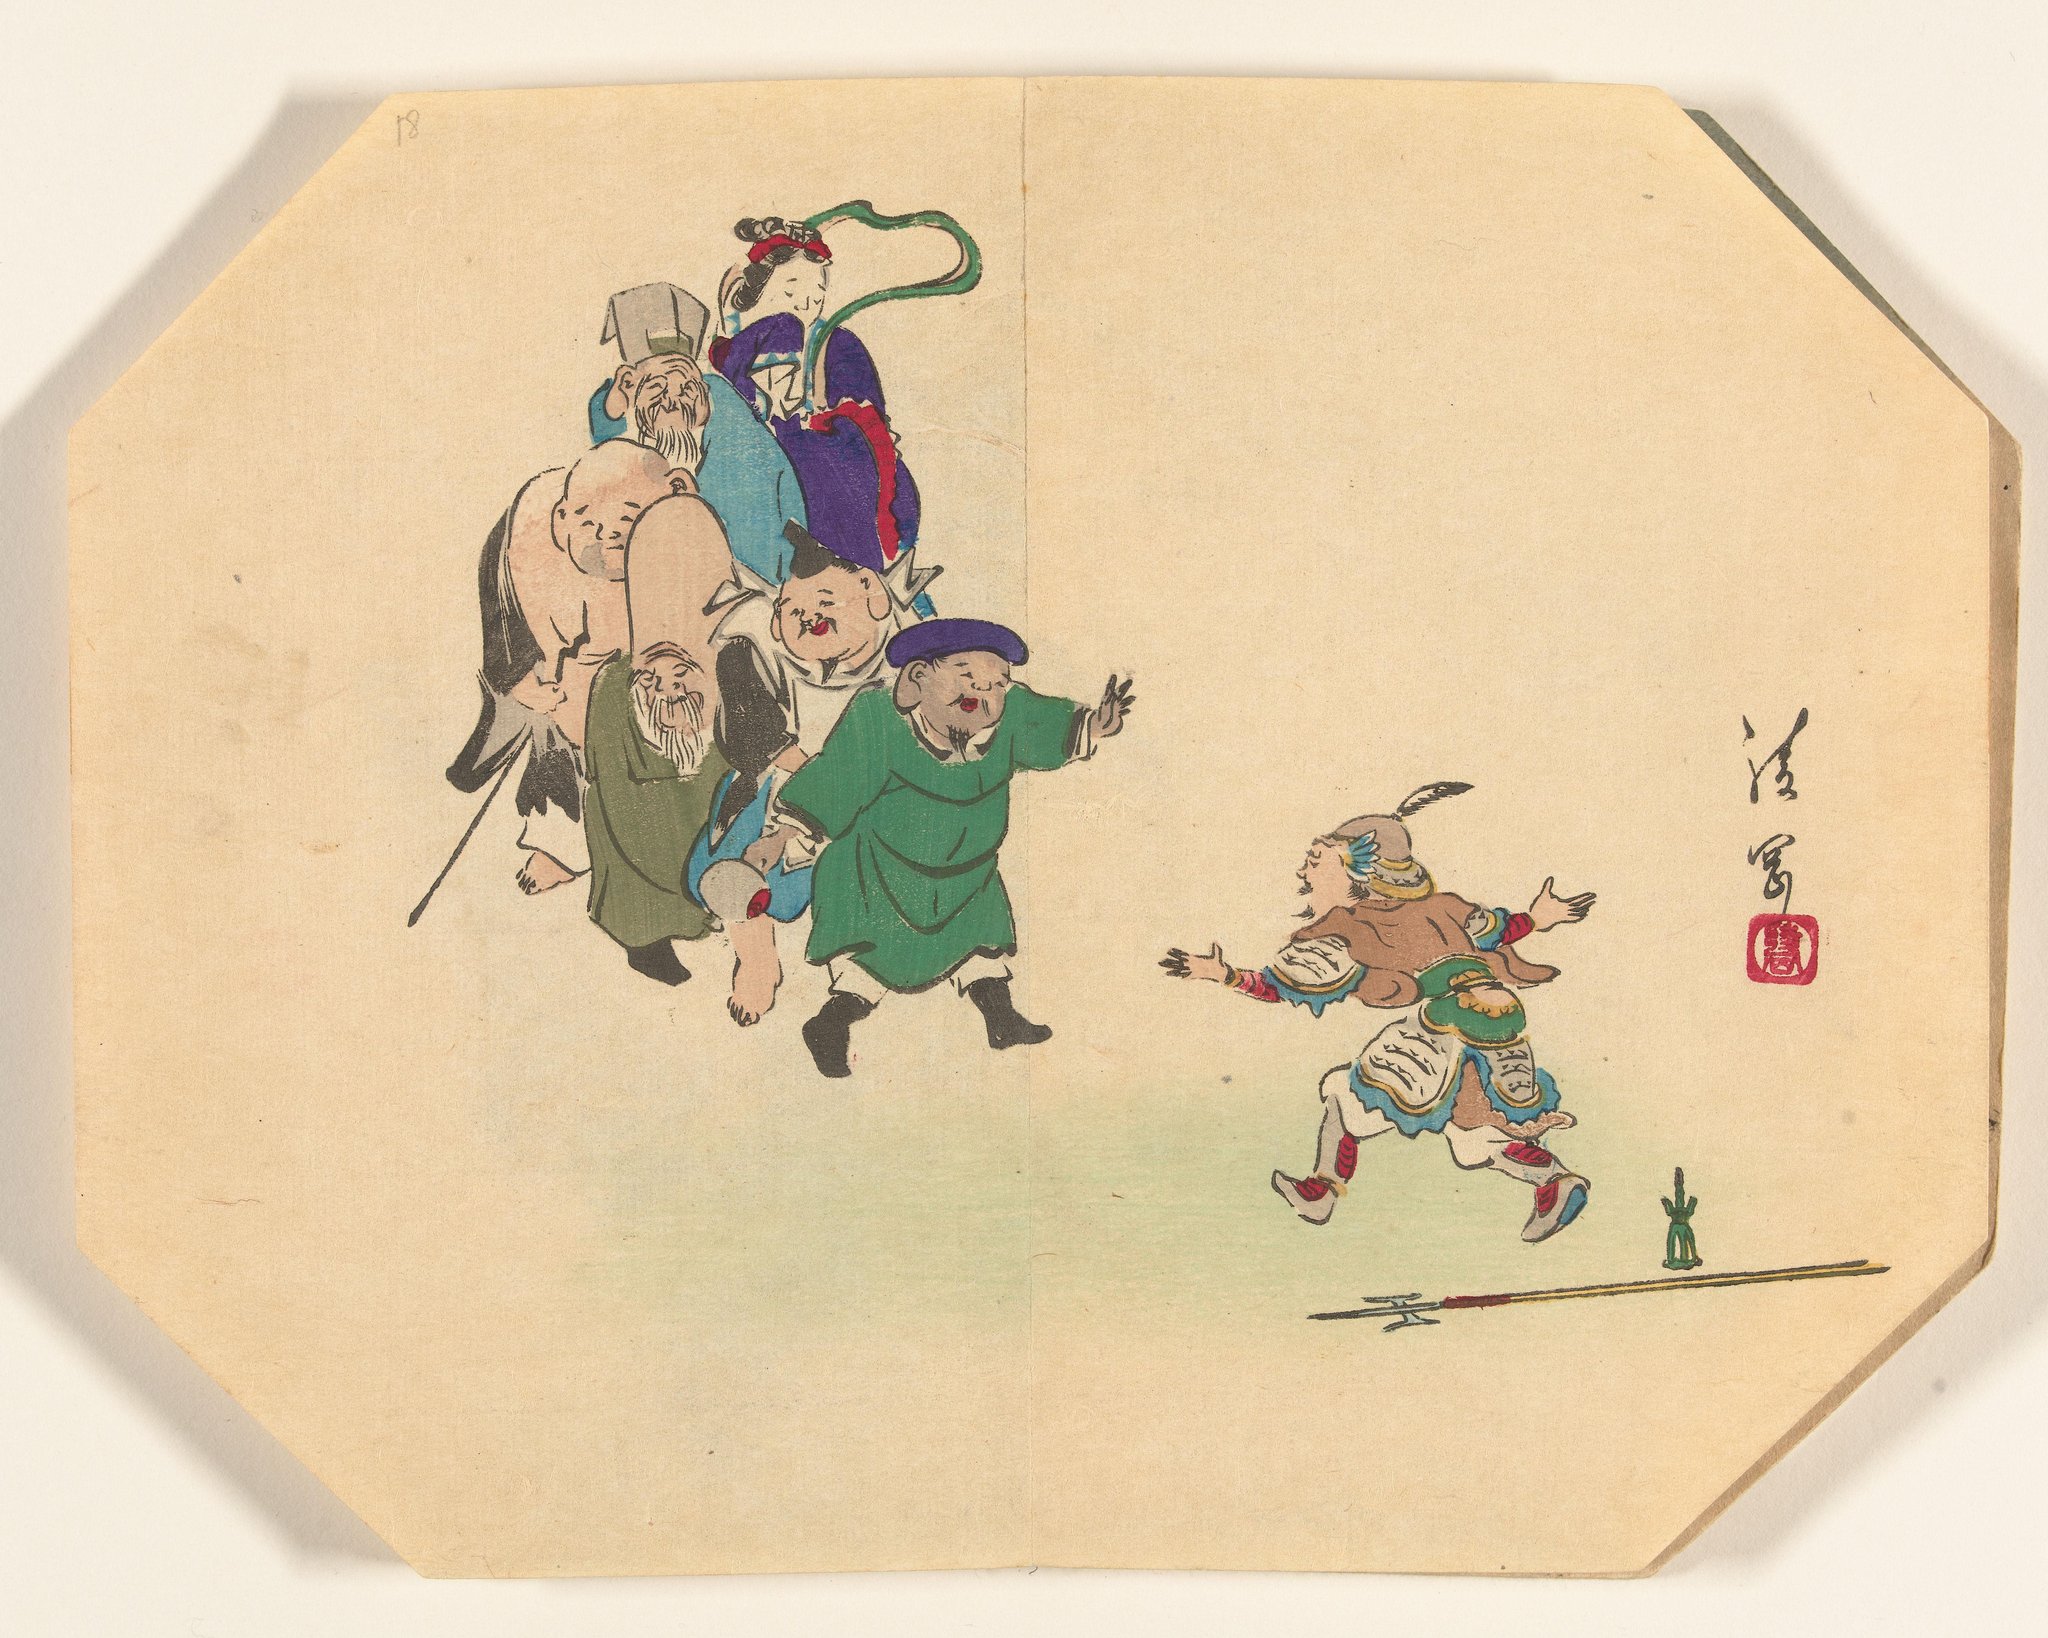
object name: album leaf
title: Bishamon verwelkomt de andere geluksgoden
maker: ayaoka yûshin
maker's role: print maker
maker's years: 1846-1910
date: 1880-1890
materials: paper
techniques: woodcut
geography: japan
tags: being welcomed ~ travelling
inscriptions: collector's mark: Lugt 2228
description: Octogonale prent in album met 39 prenten.